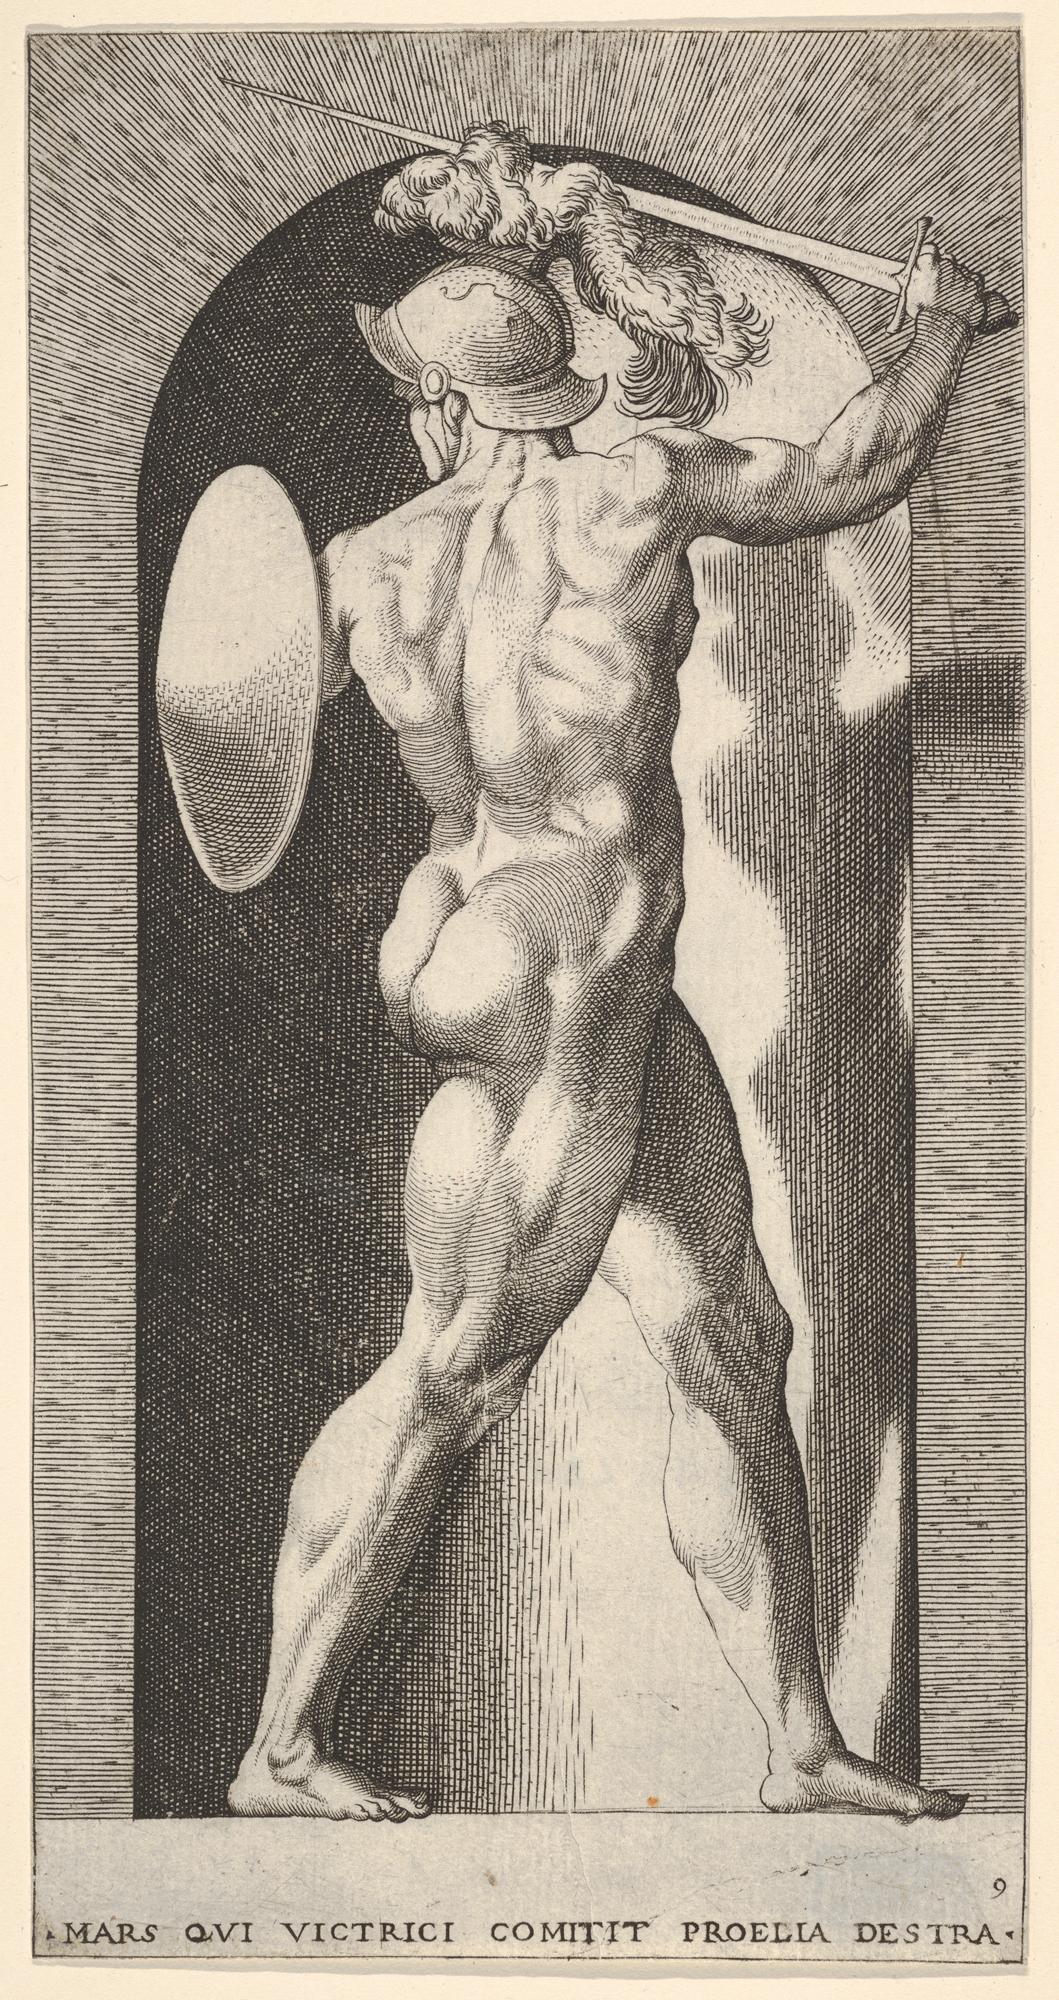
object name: print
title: Plate 9: Mars in a niche, holding a sword above his head with his right arm, and a shield on his left arm, from "Mythological Gods and Goddesses"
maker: giovanni jacopo caraglio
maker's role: artist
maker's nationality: italian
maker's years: 1500-1565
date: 1526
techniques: engraving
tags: shields,swords,mars